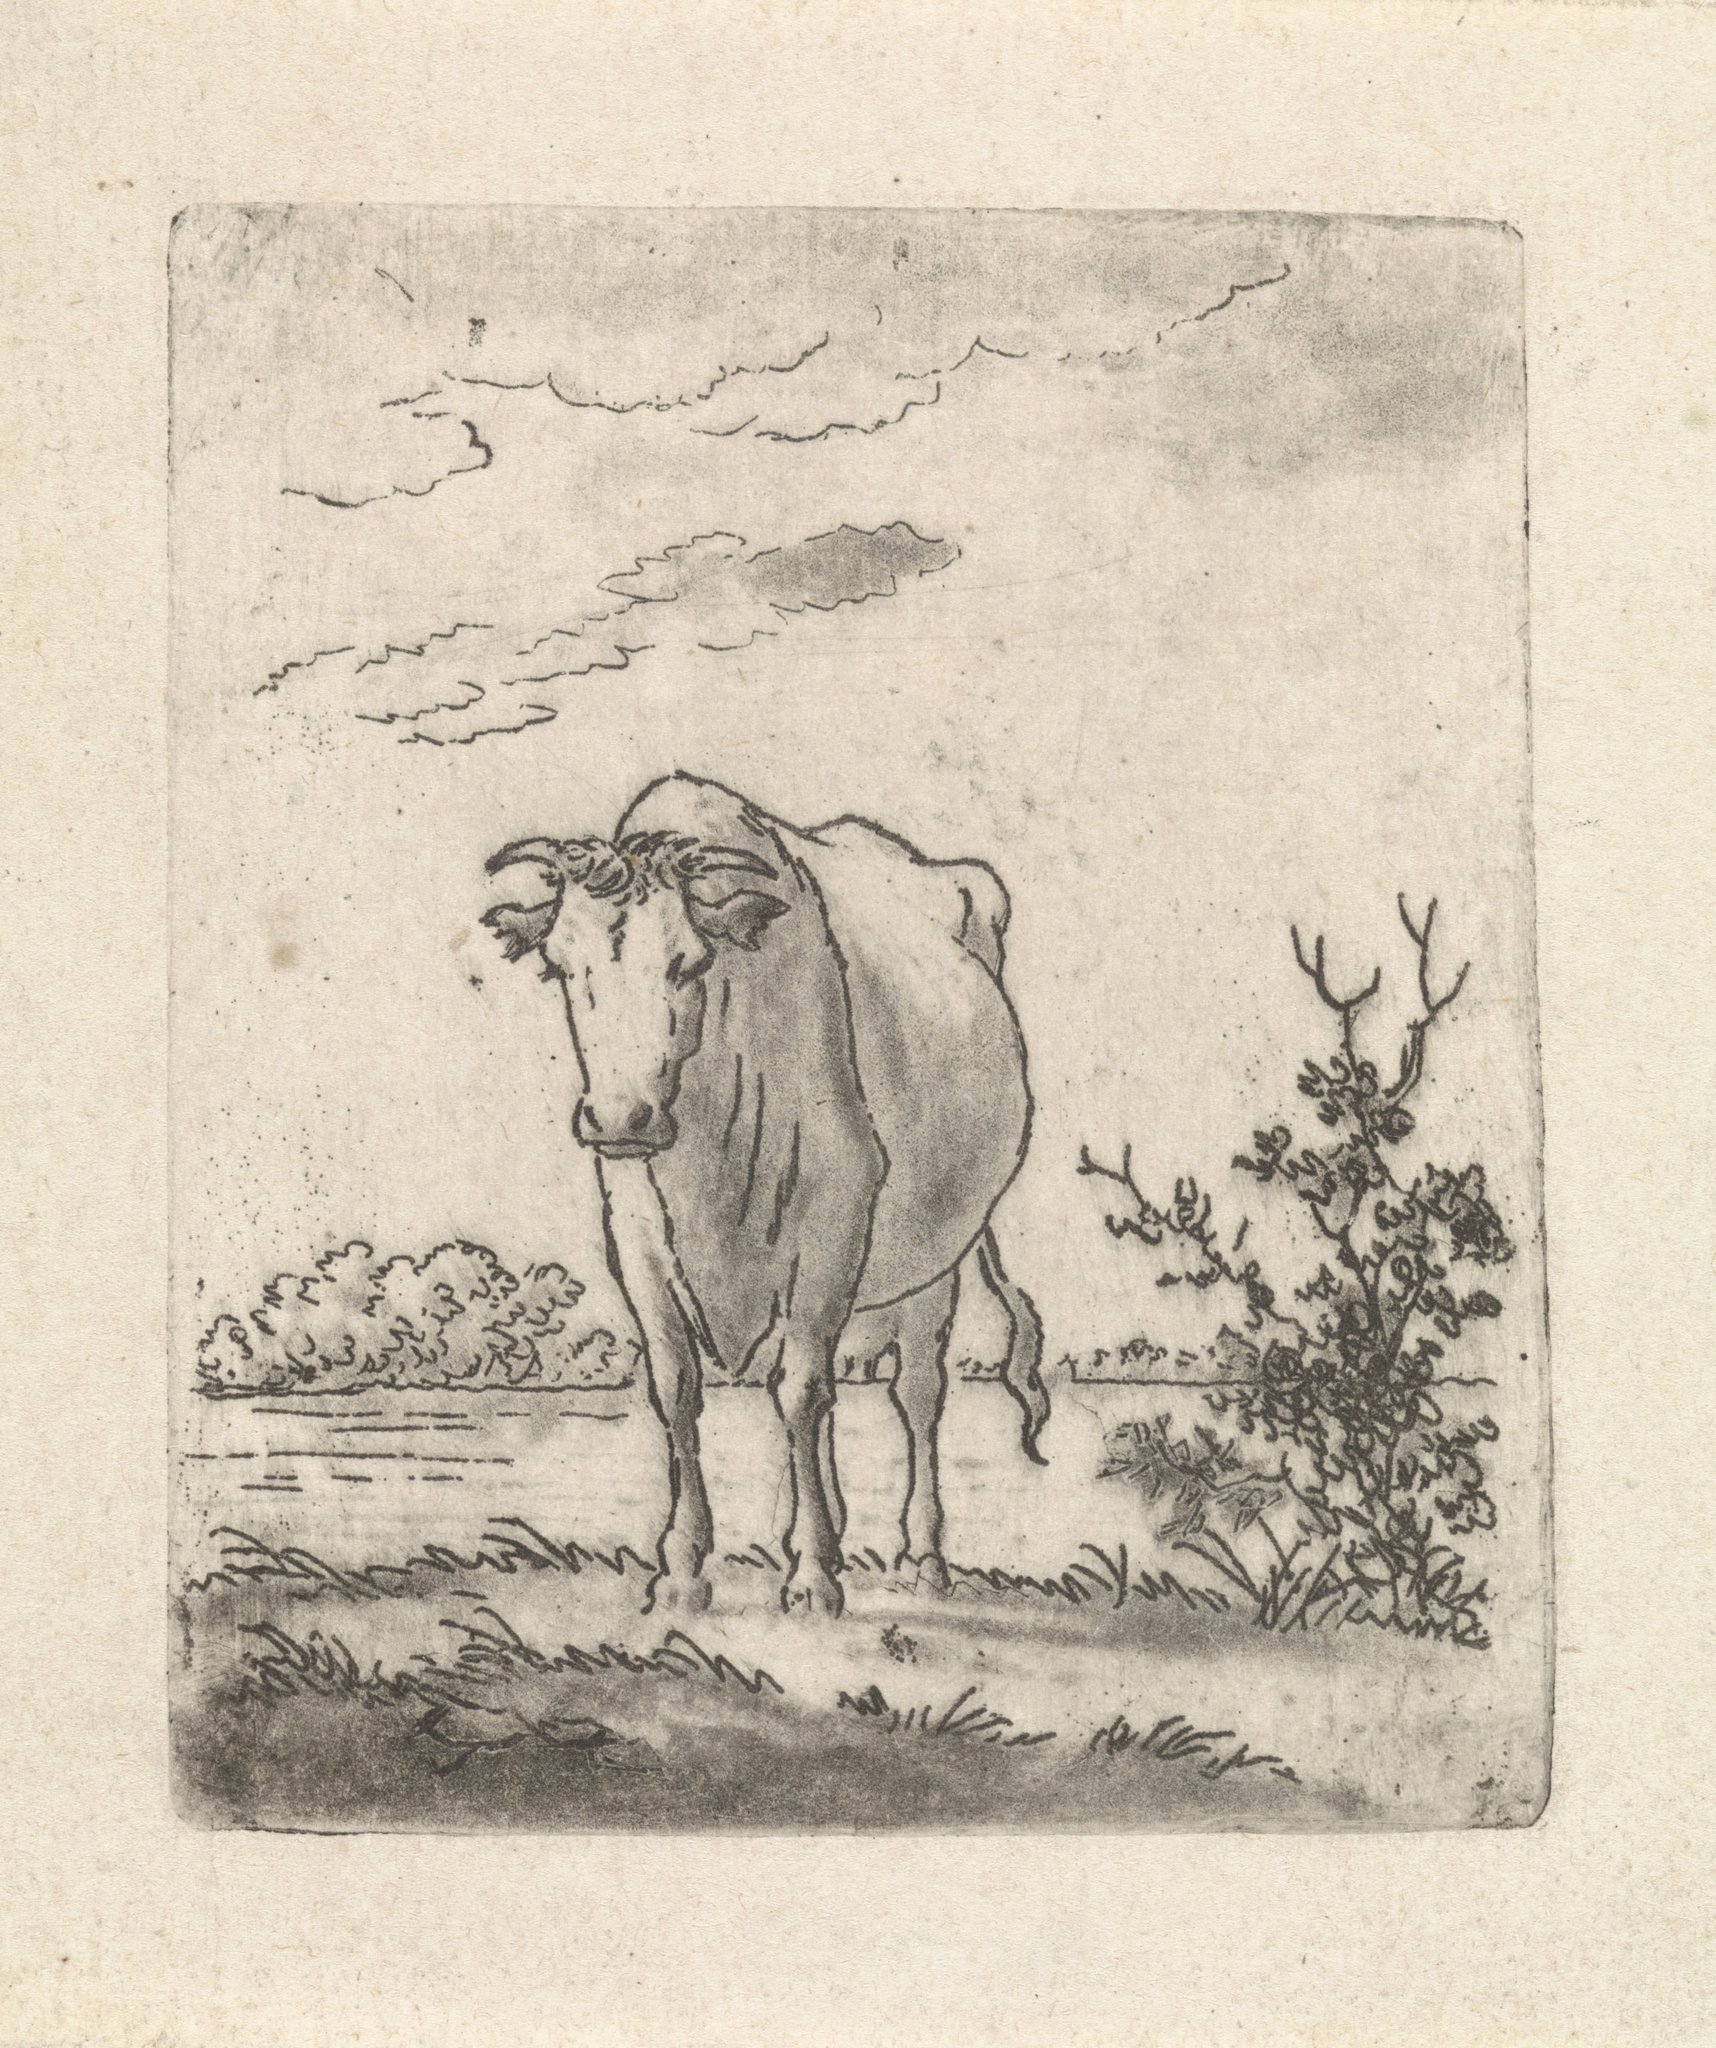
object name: print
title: Koe, van voren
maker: pieter janson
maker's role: draughtsman, print maker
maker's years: 1765-1851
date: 1780-1851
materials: chalk, paper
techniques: etching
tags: cow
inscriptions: collector's mark: Lugt 240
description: Koe, van voren, staand aan de waterkant. Rechts op de voorgrond een struik.